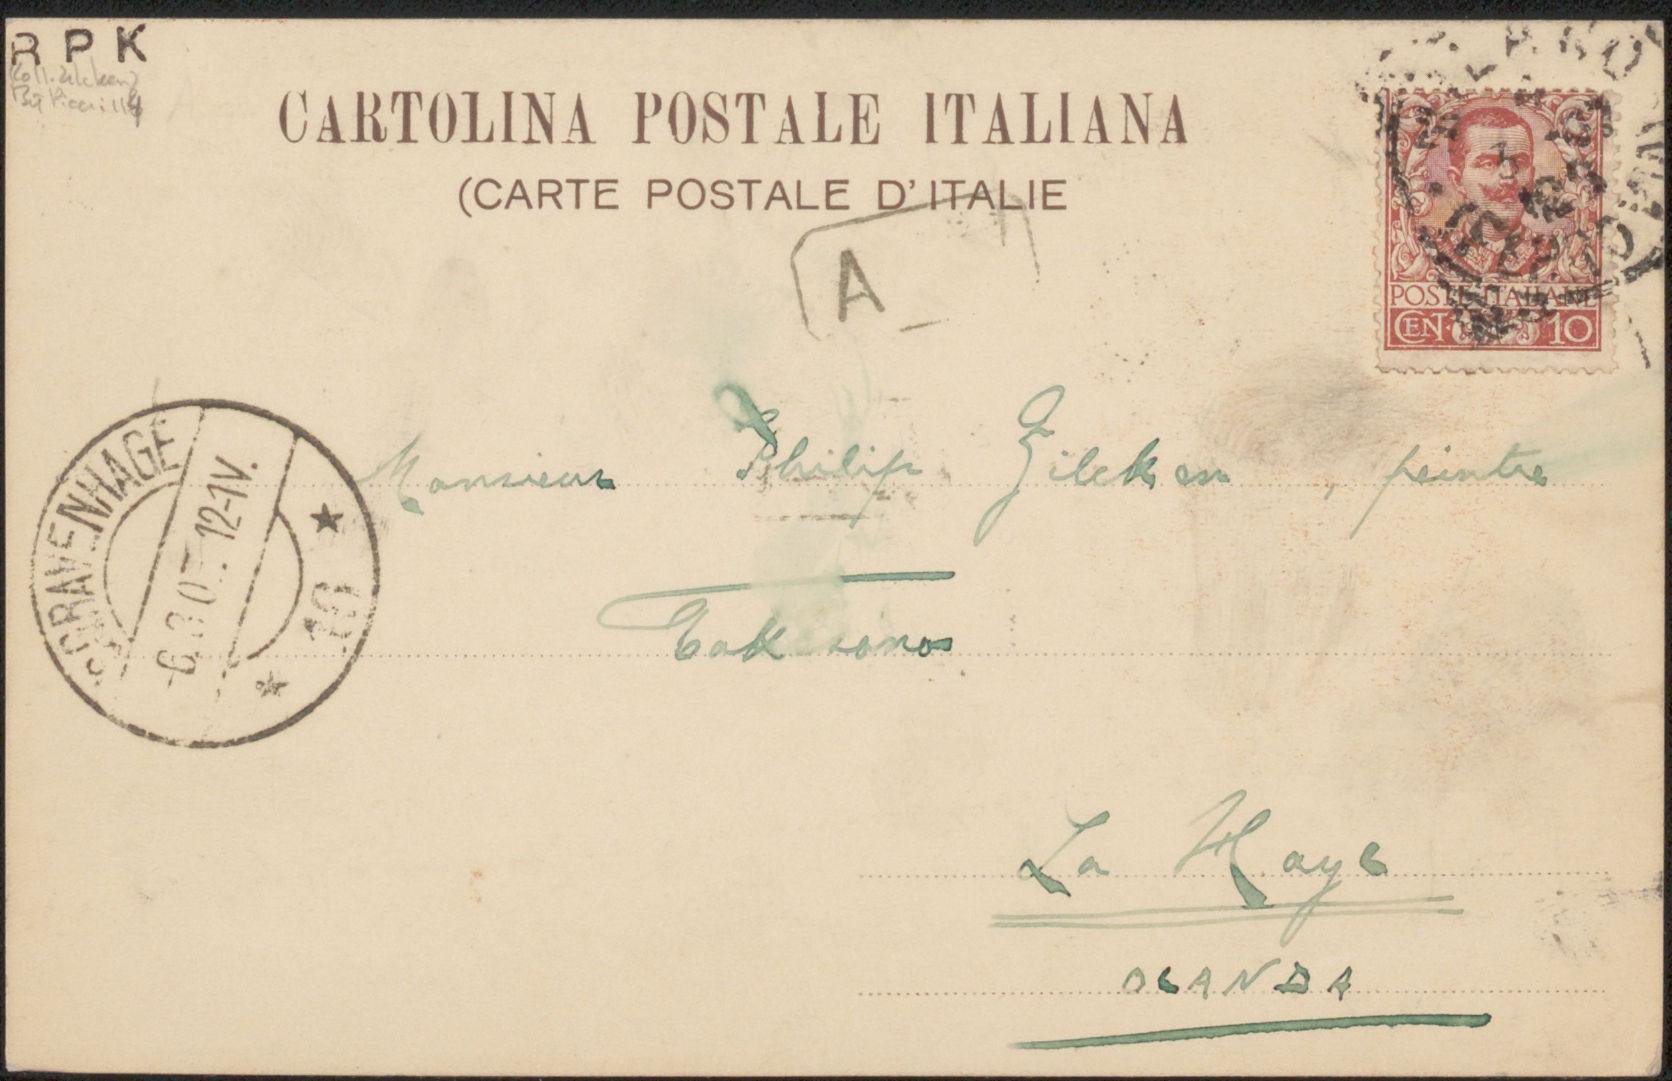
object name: postcard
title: Briefkaart aan Philip Zilcken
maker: vittorio pica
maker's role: criticus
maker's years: 1864-1930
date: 1907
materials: cardboard, ink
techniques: pen, printing, writing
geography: milan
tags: venice, rome, politician, antonio fradeletto, the hague, painter, philip zilcken, drawing, exhibition ~ art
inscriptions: collector's mark: ‘RPK’